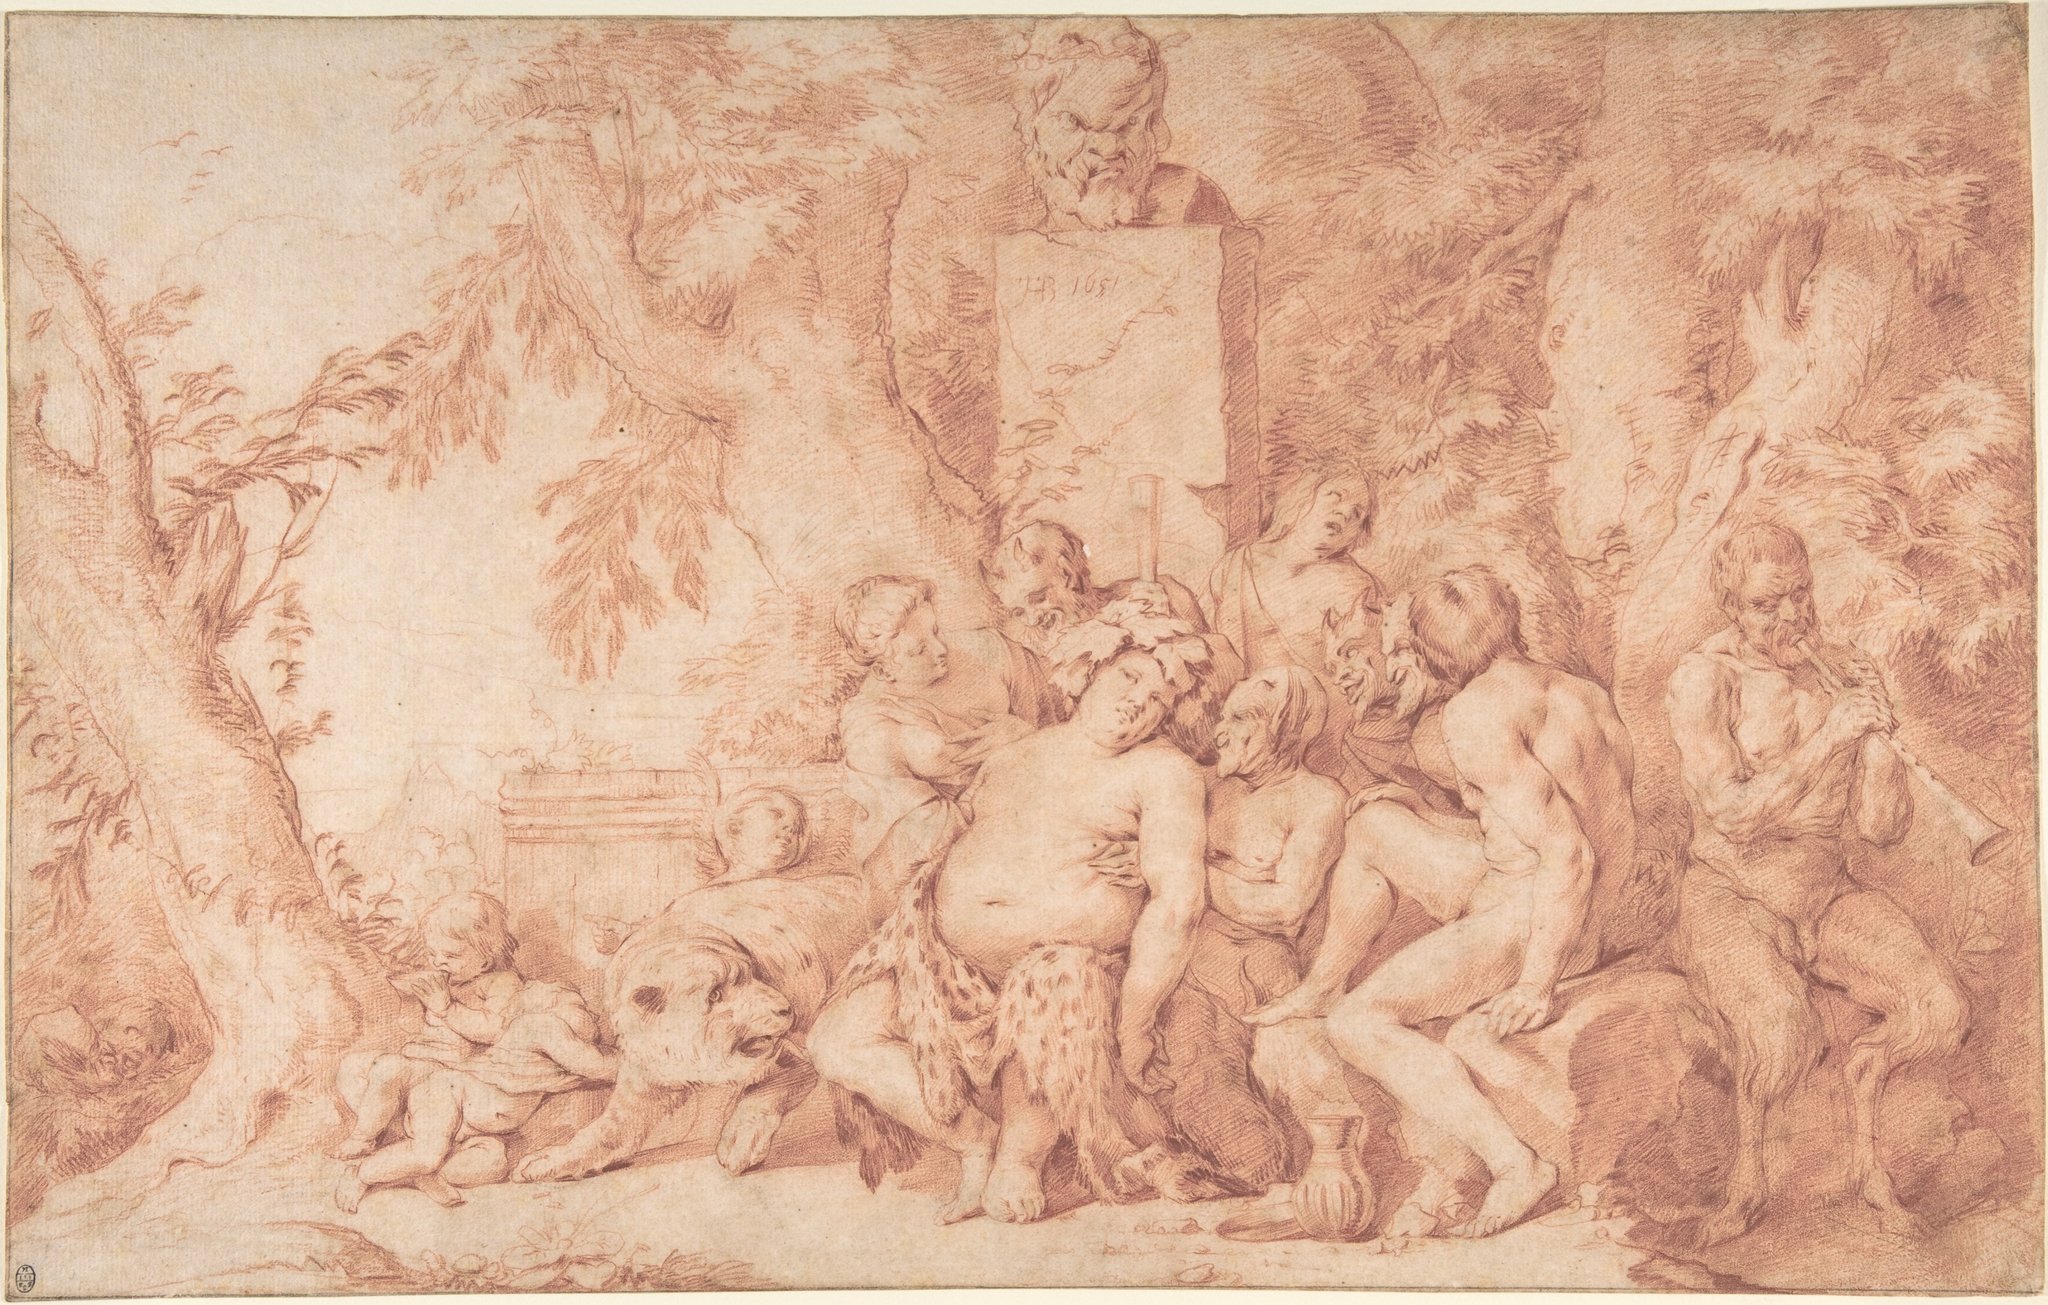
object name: drawing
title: Bacchanalian Scene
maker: hendrick berckman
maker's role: artist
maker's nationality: dutch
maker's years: 1629-1679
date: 1651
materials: chalk, graphite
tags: musical instruments,animals,children,male nudes,women,satyrs